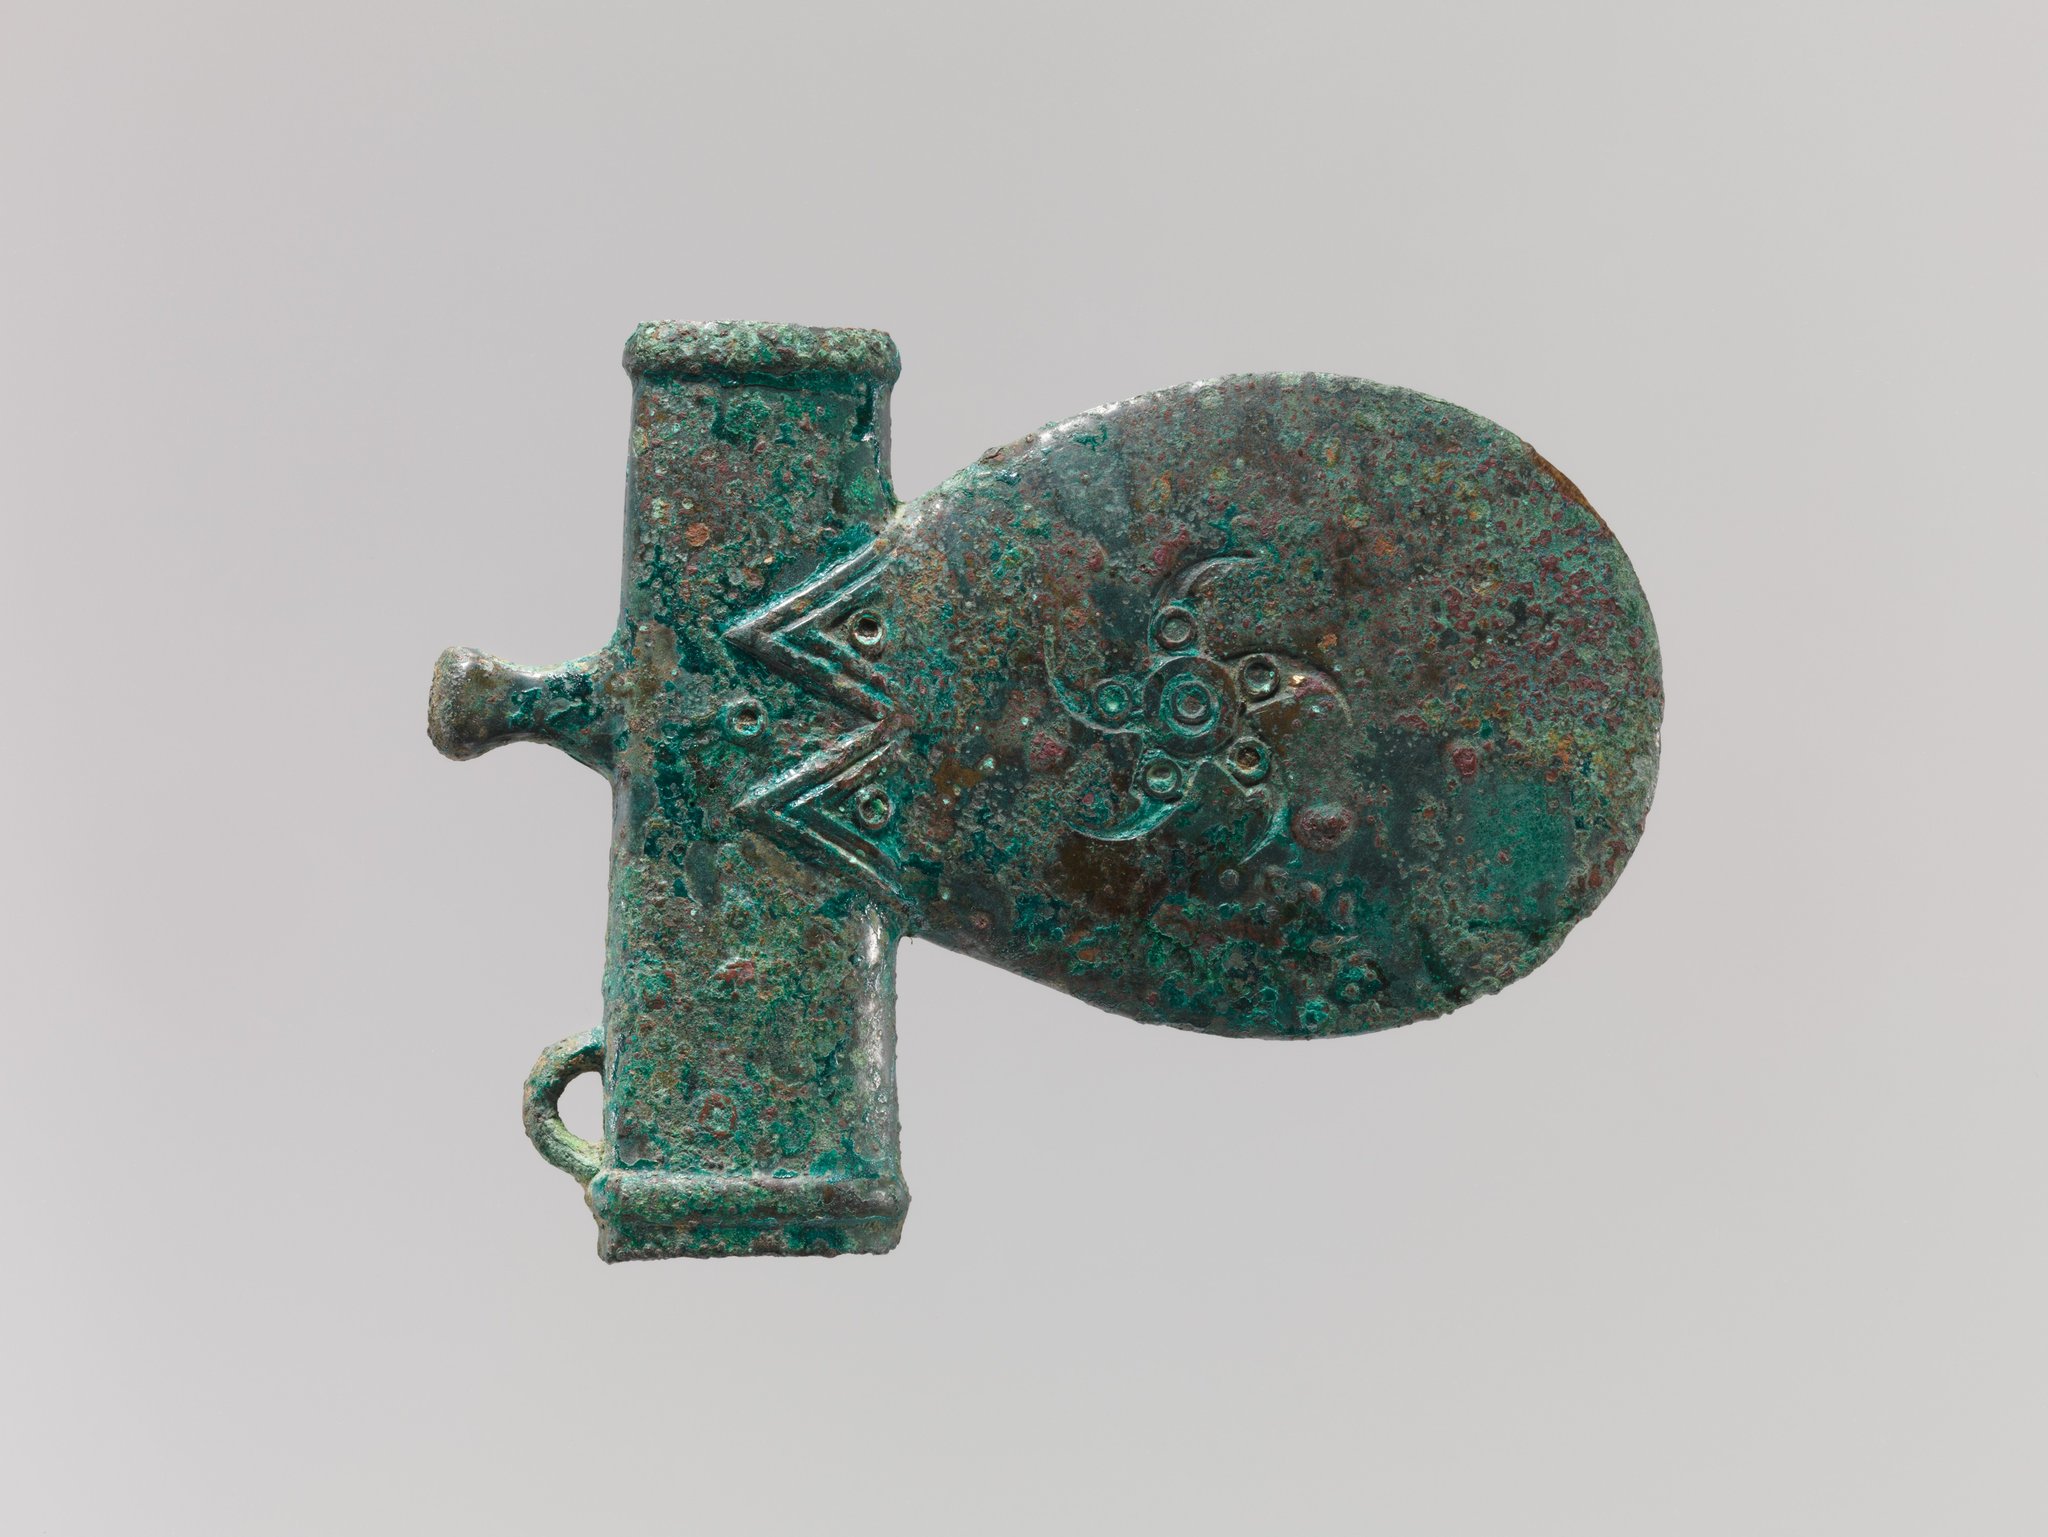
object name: ax head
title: Ax Head with Oval-Shaped Blade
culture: chinese, northeast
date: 1000-701 BCE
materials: bronze